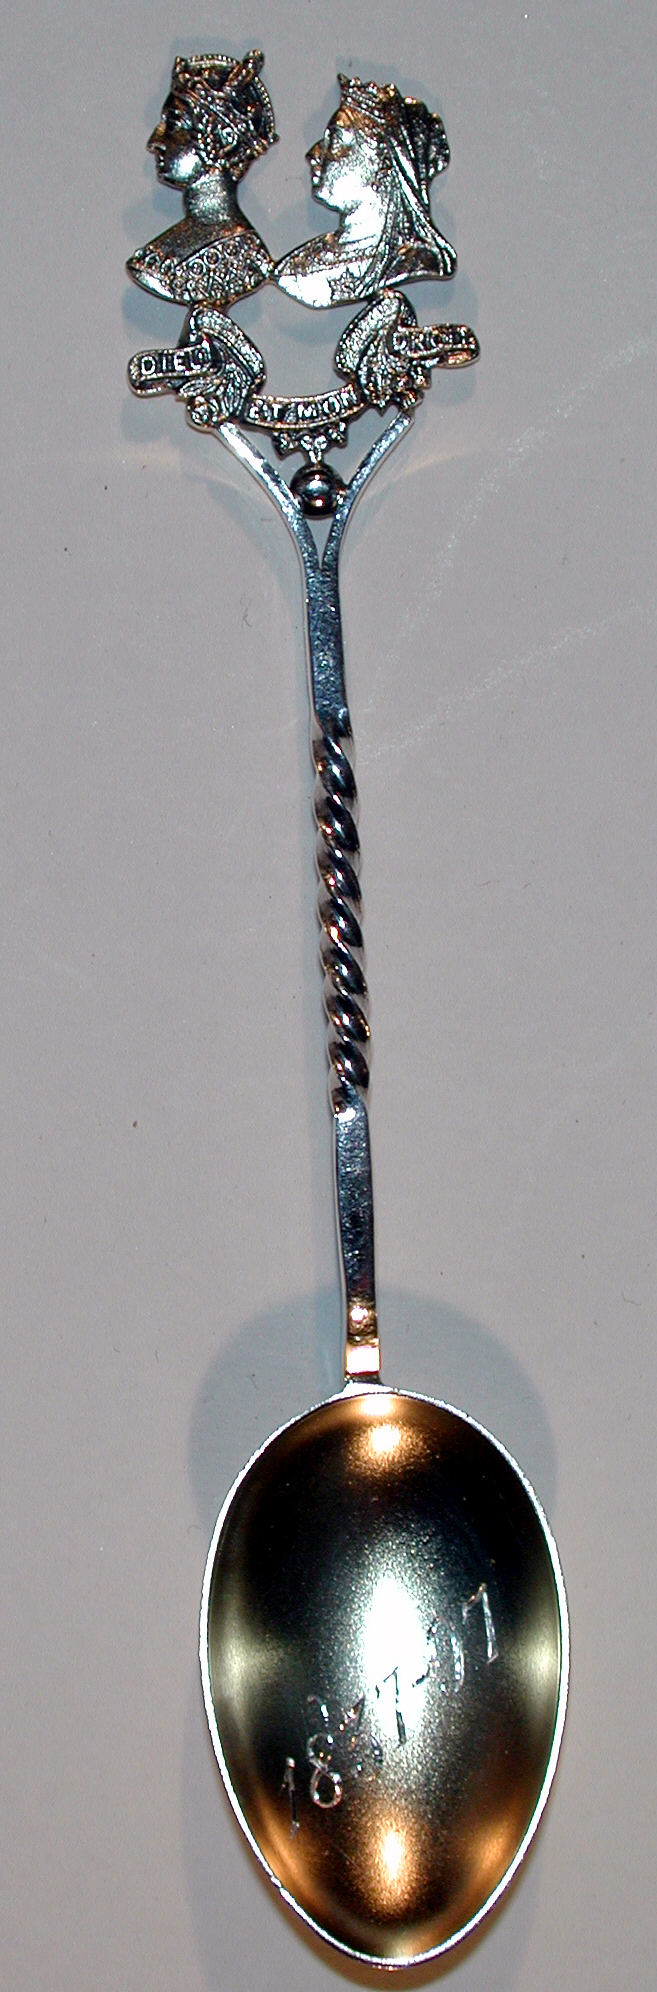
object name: souvenir spoon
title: Souvenir spoon with profile portraits of Queen Victoria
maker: saunders & shepherd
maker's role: maker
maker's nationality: british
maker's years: 1869-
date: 1896-1897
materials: silver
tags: men,profiles